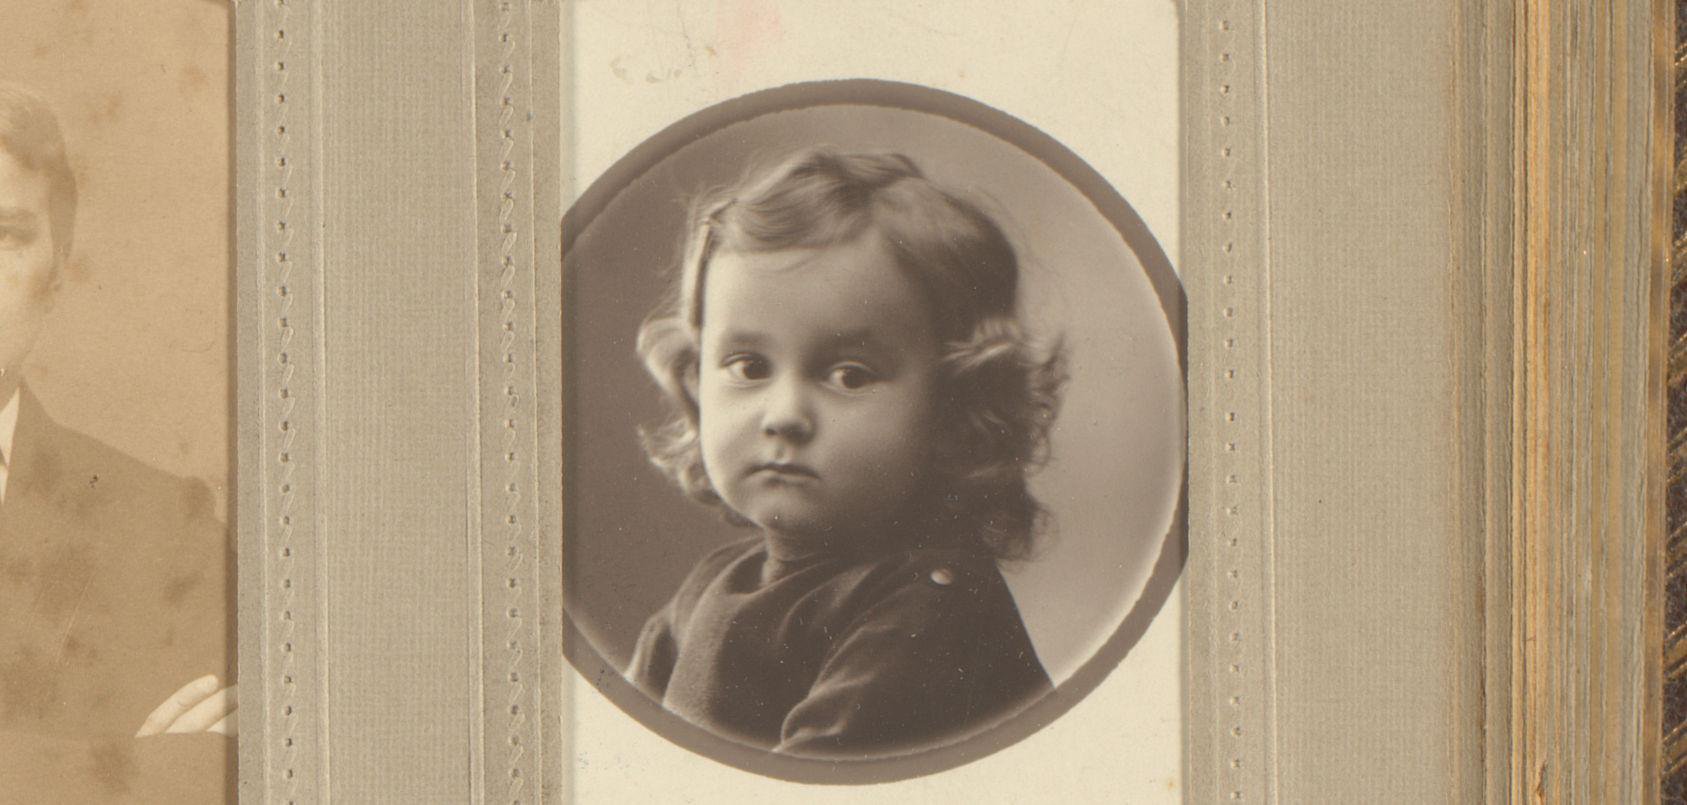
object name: photograph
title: Portret van Dolphje, op twee-en een halfjarige leeftijd; Kersttijd 1913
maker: geldolph adriaan kessler (dolph)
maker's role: fotograaf, industrieel, voetballer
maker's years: 1884-1945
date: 1912-1913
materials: paper, photographic support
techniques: gelatin silver print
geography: netherlands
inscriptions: annotation: ‘Kersttijd 1913 Dolphje, 2 1/2 jaar oud’